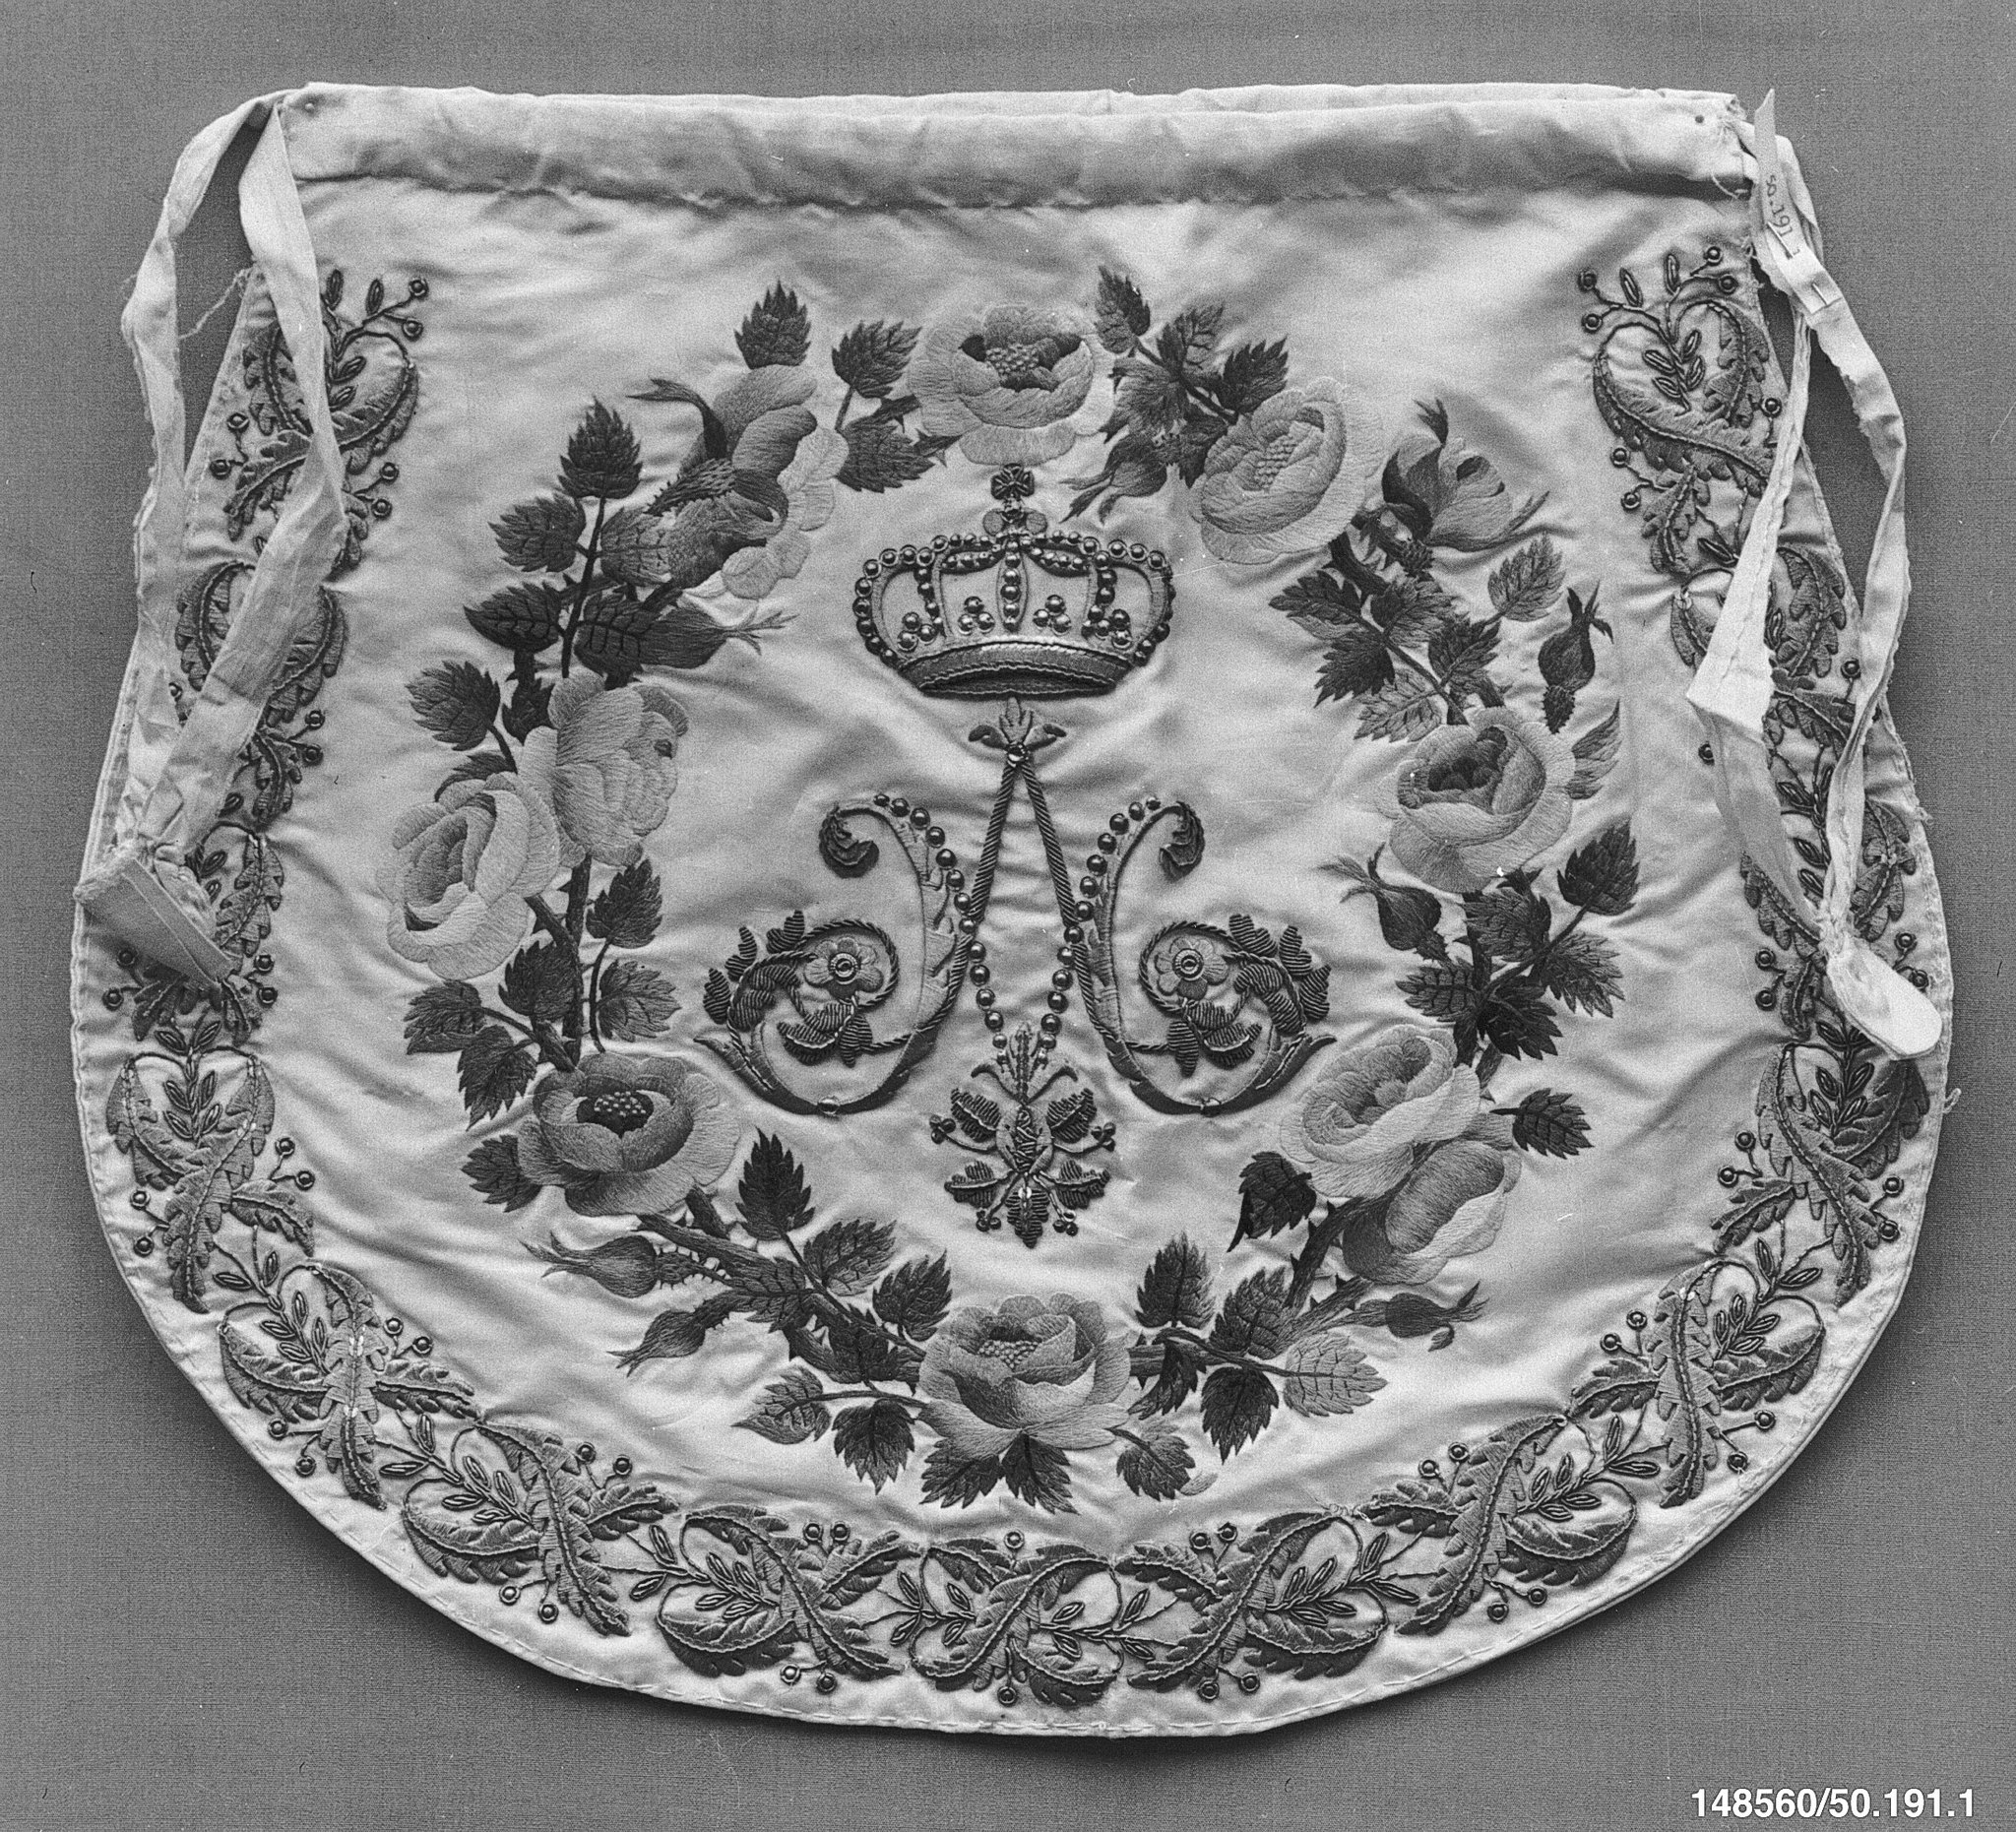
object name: bag or statue robe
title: Bag or statue robe (?)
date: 1801-1850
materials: metal thread, silk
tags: flowers